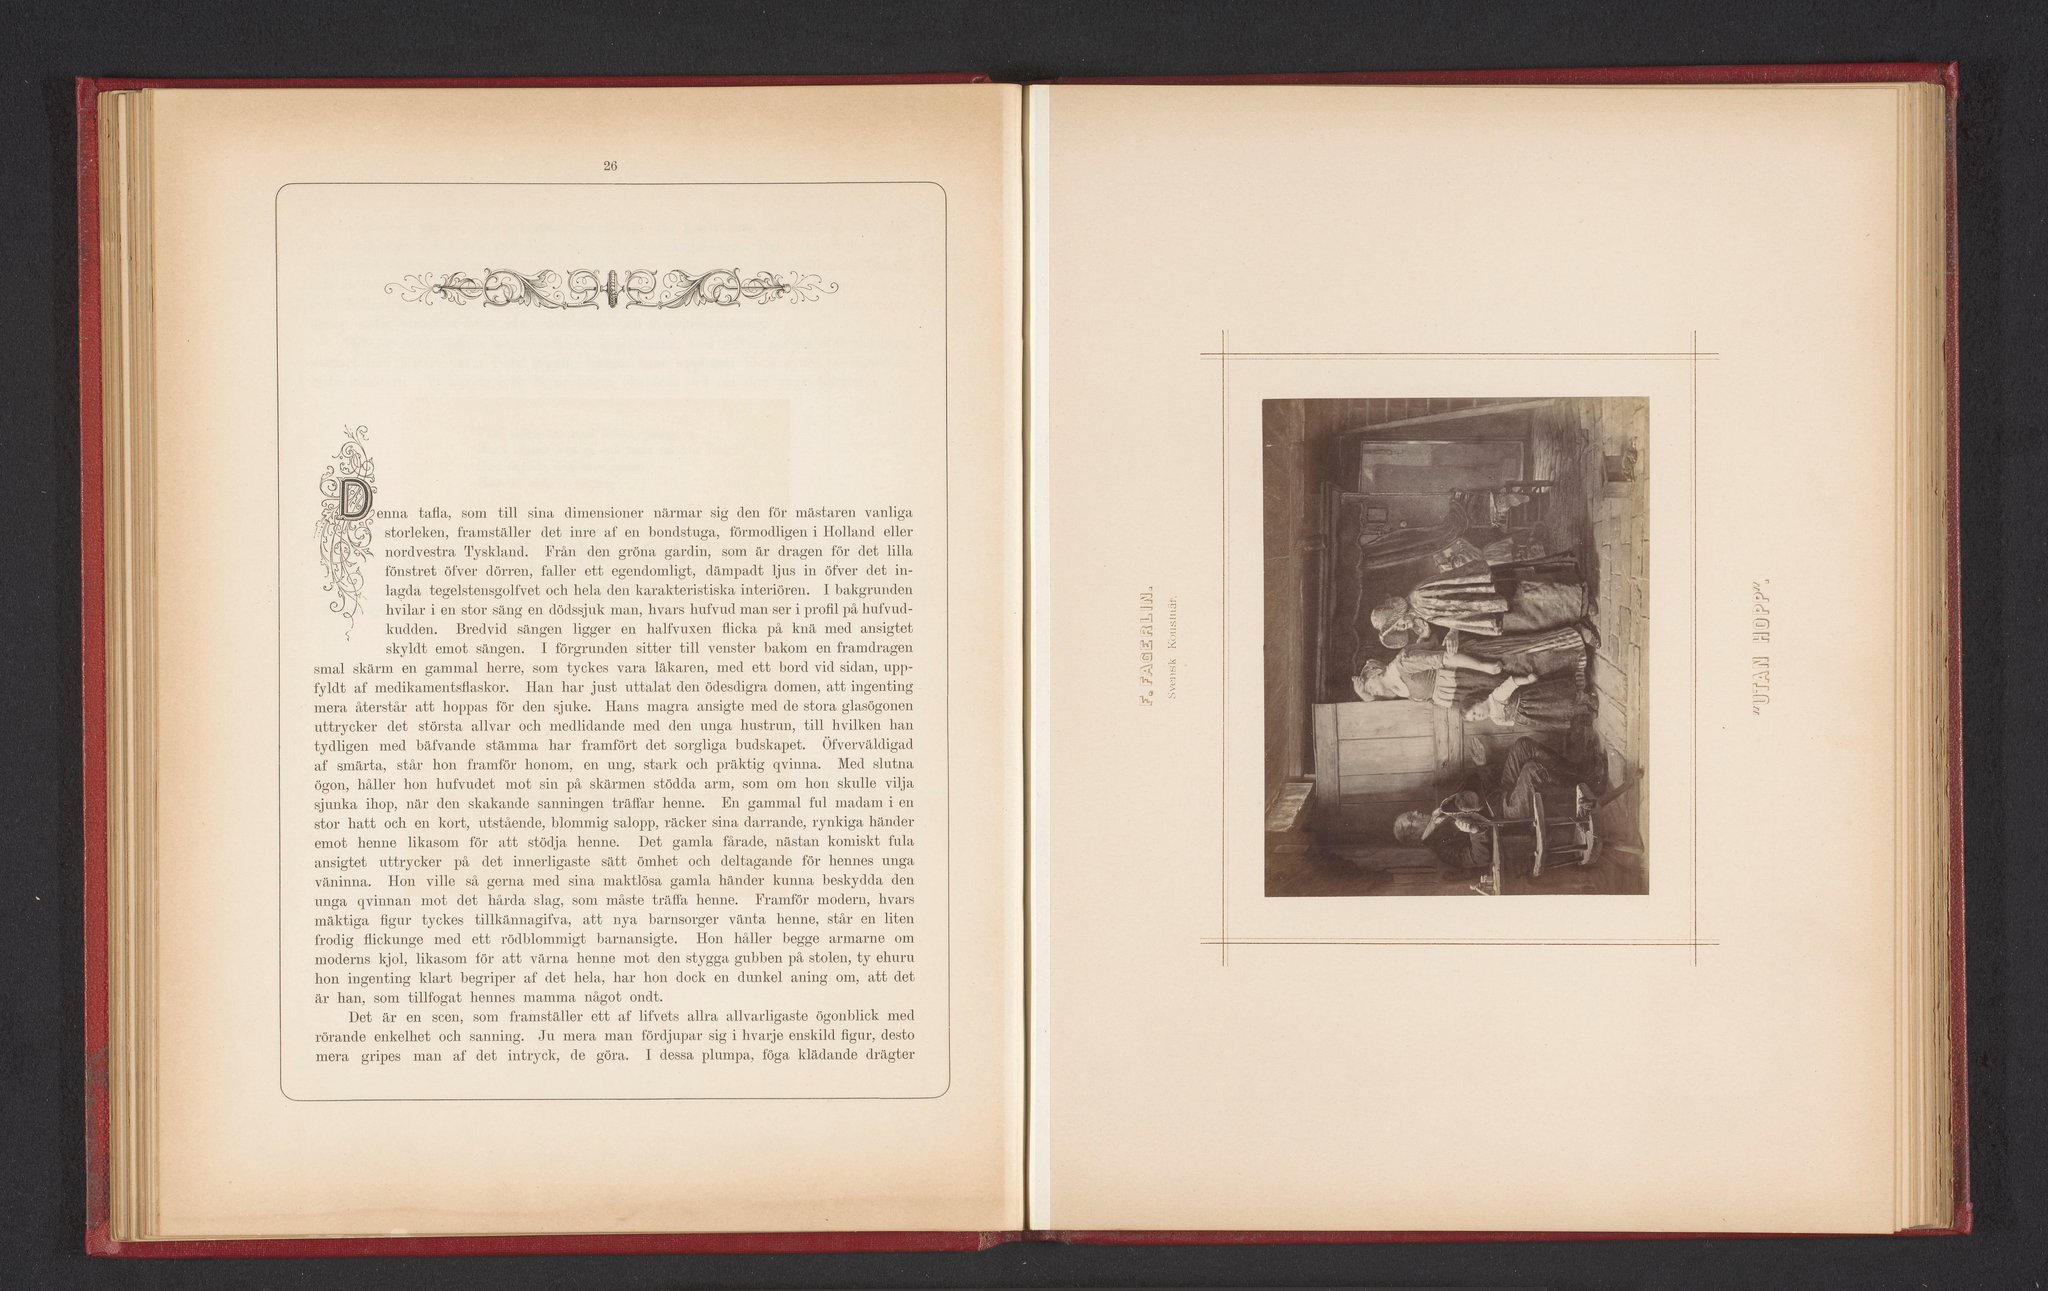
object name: page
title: Fotoreproductie van een schilderij van een moedeloze vrouw en haar gezin door Ferdinand Fagerlin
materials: photographic support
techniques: albumen print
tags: adult woman, family life at home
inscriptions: inscription: ‘Svensk Konstnär.’